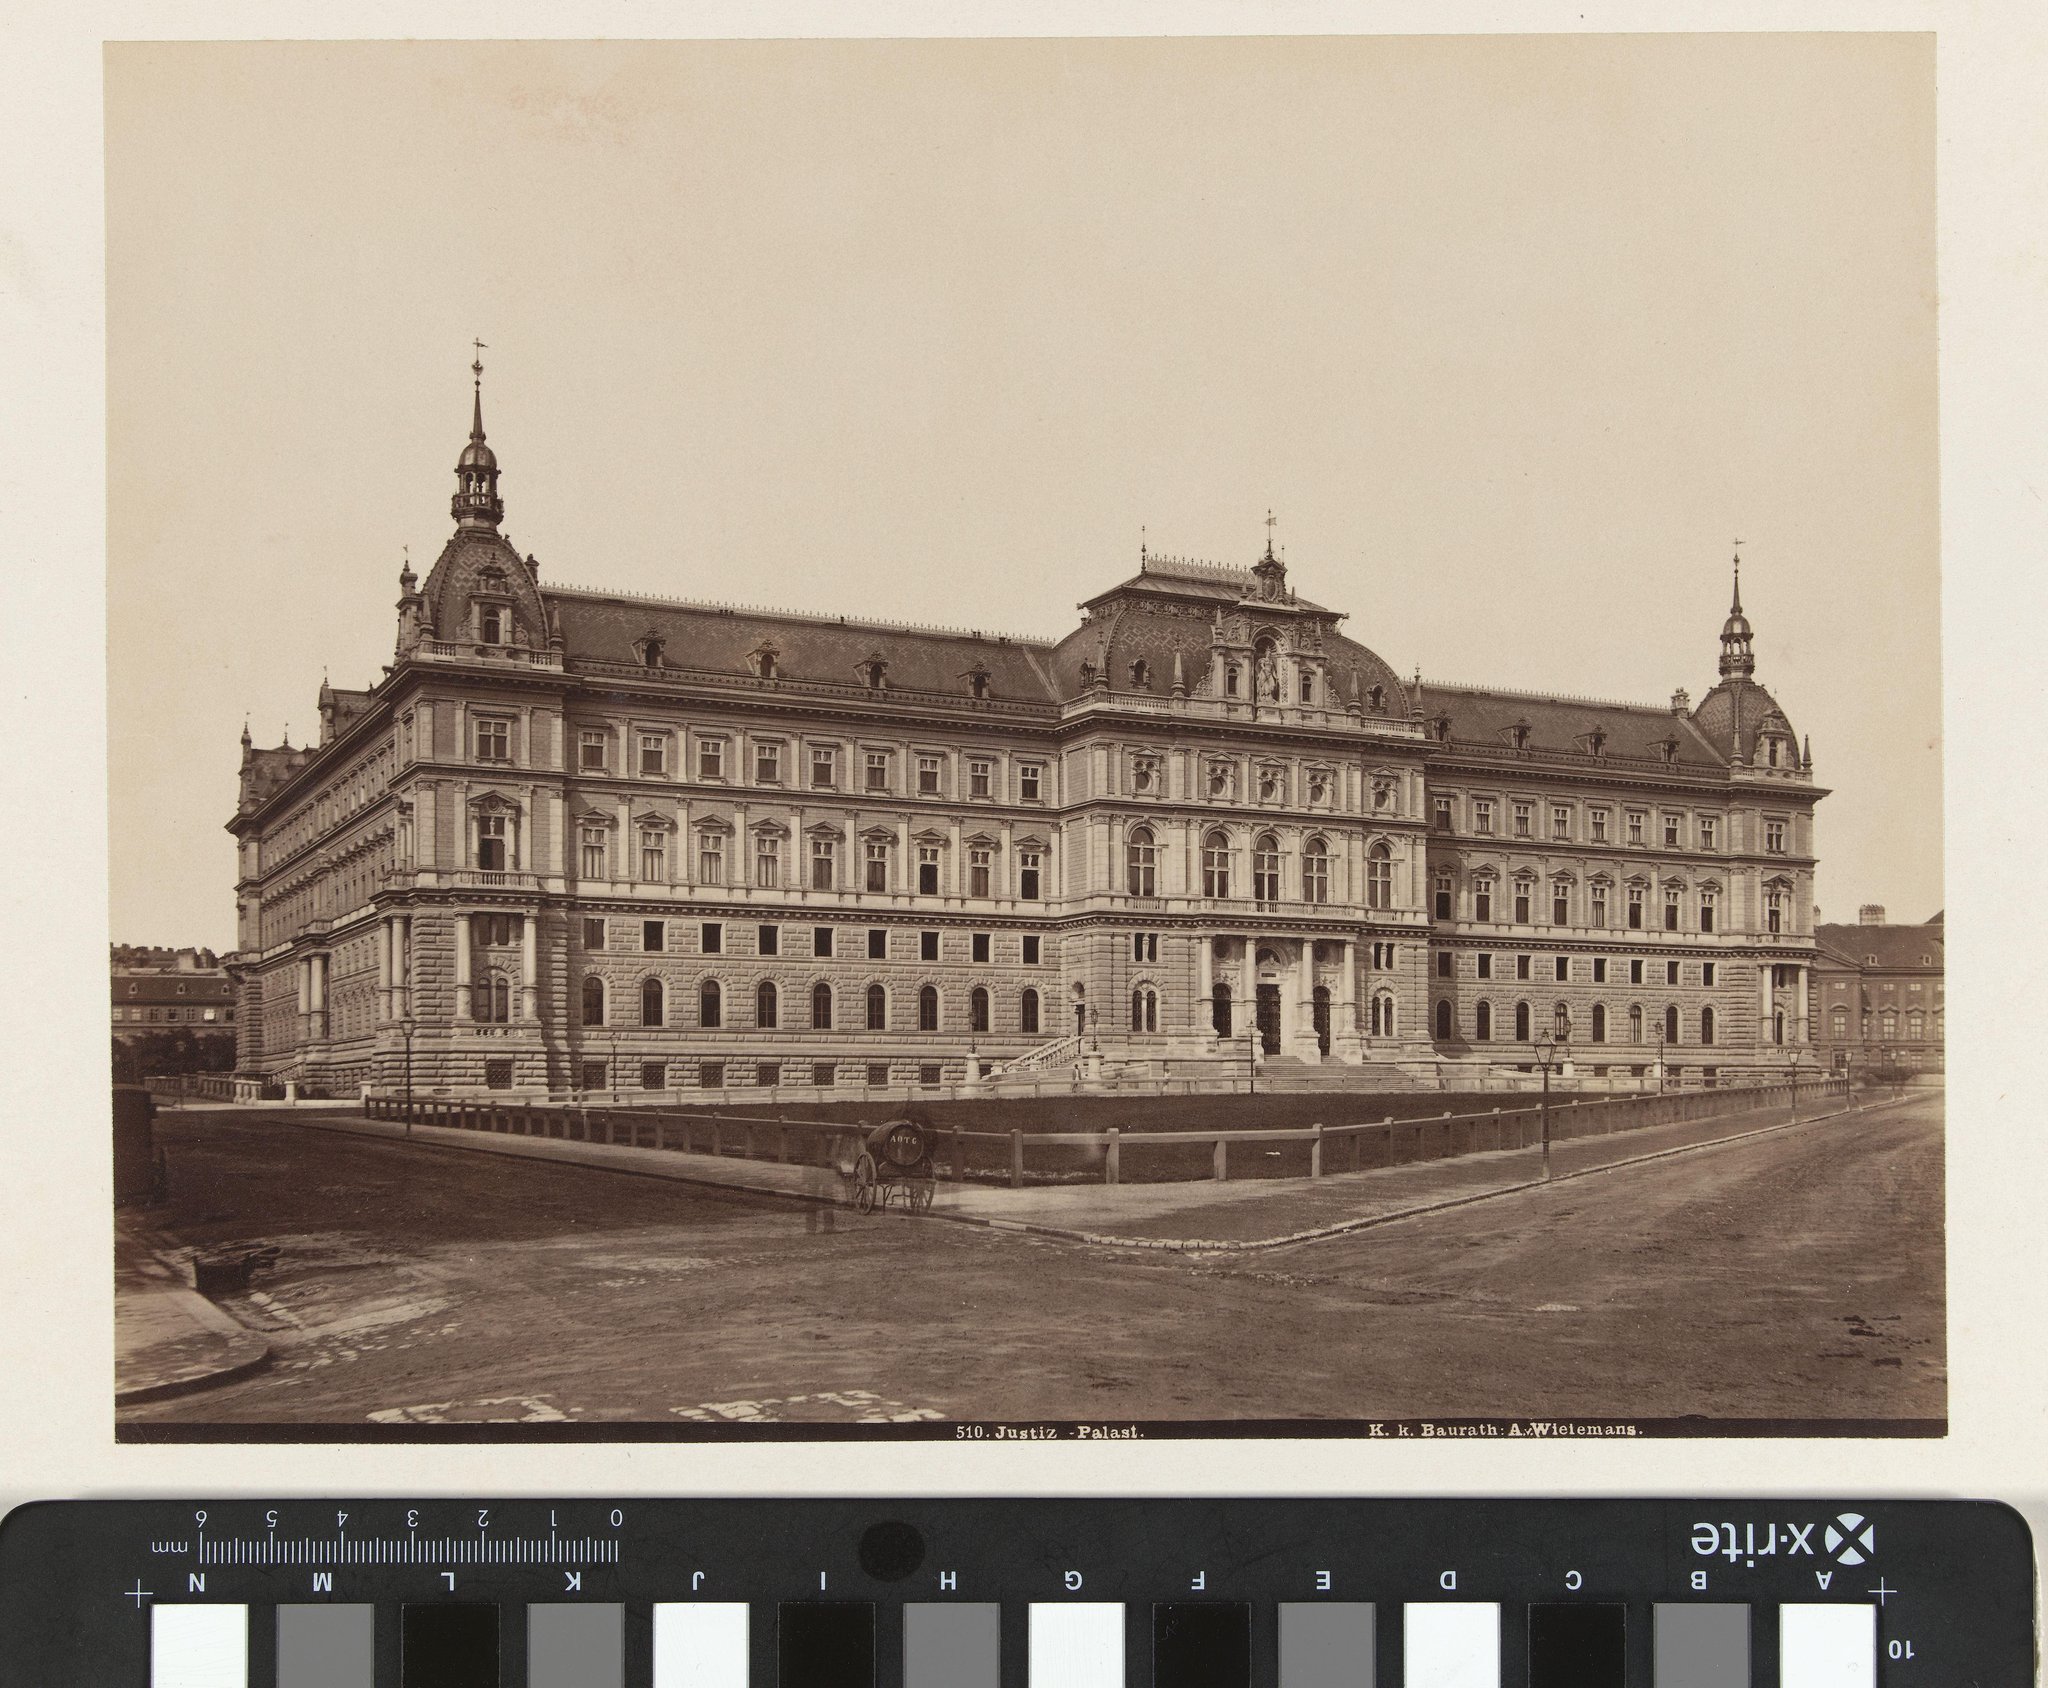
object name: photograph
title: Justiz-Palast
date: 1881-1900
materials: cardboard, paper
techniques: albumen print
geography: vienna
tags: court building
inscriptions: number: ‘510’, inscription: ‘K.k. Baurath: A. v. Wielemans.’